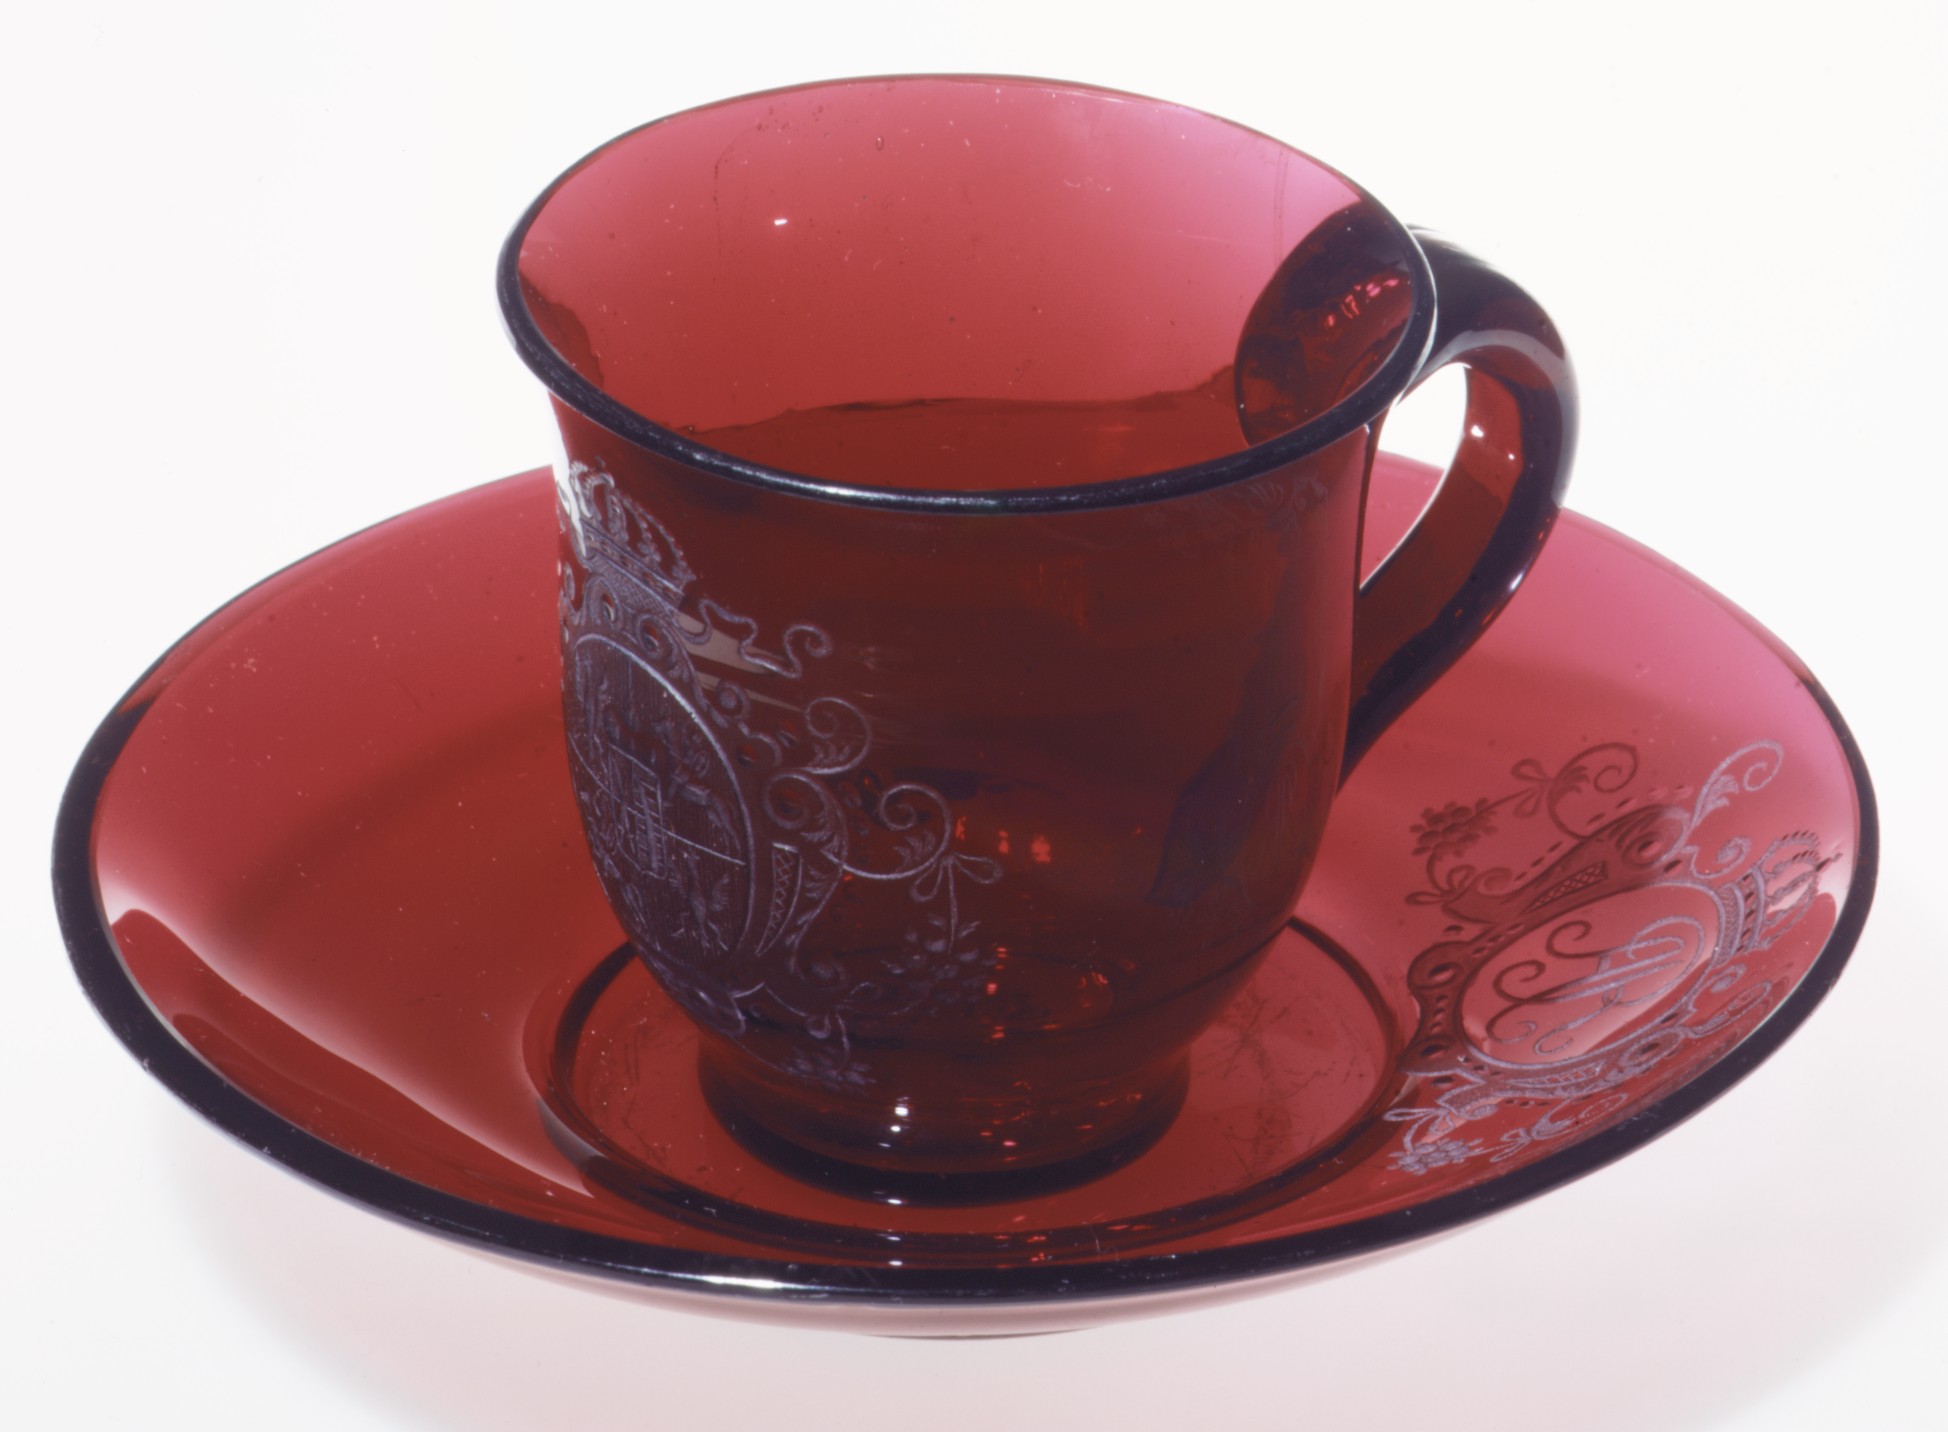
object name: saucer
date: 1730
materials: glass